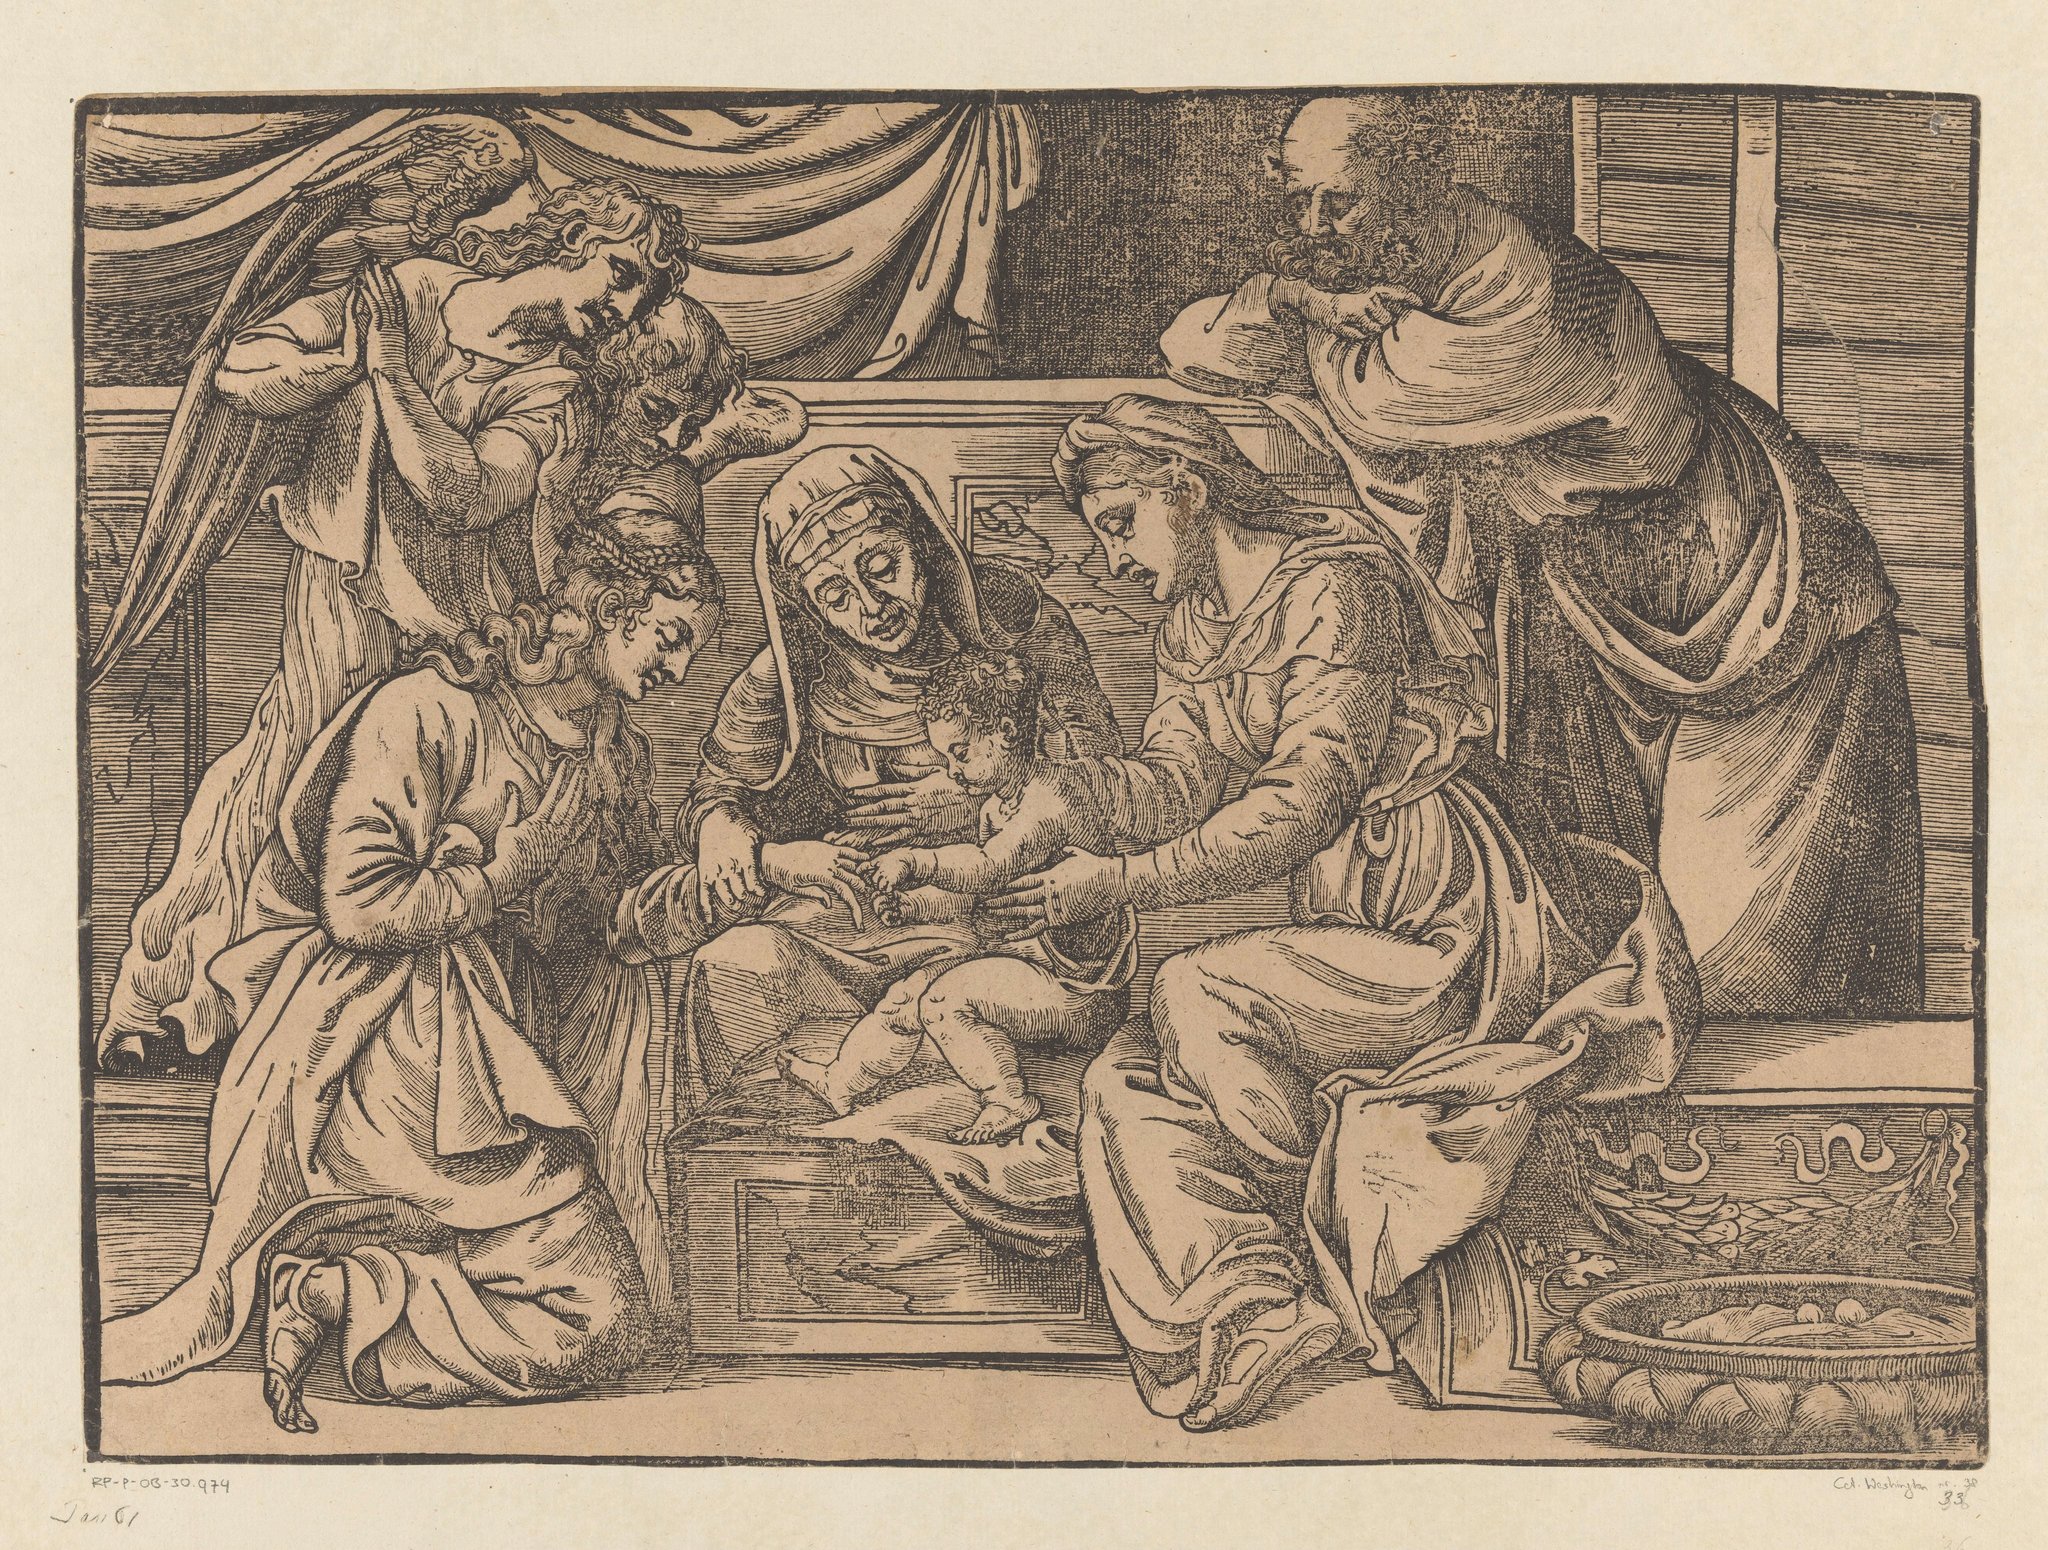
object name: print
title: Mystieke huwelijk van de Heilige Catharina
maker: nicolò boldrini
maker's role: painter, print maker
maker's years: 1500-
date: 1540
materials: paper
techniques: woodcut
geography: italy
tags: the foster-father of christ, joseph of nazareth, husband of mary; possible attributes: flowering rod or wand, lily, carpenter's tools, the mystic marriage of st. catherine of alexandria with the infant christ: the christ-child puts a ring on her finger, angels in adoration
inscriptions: collector's mark: Lugt 240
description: Maria houdt het Christuskind vast terwijl deze een ring om de vinger schuift van de heilige Catharina die voor hem knielt. Links twee aanbiddende engelen en rechts Jozef. In het midden een oudere vrouw, mogelijk de heilige Anna.